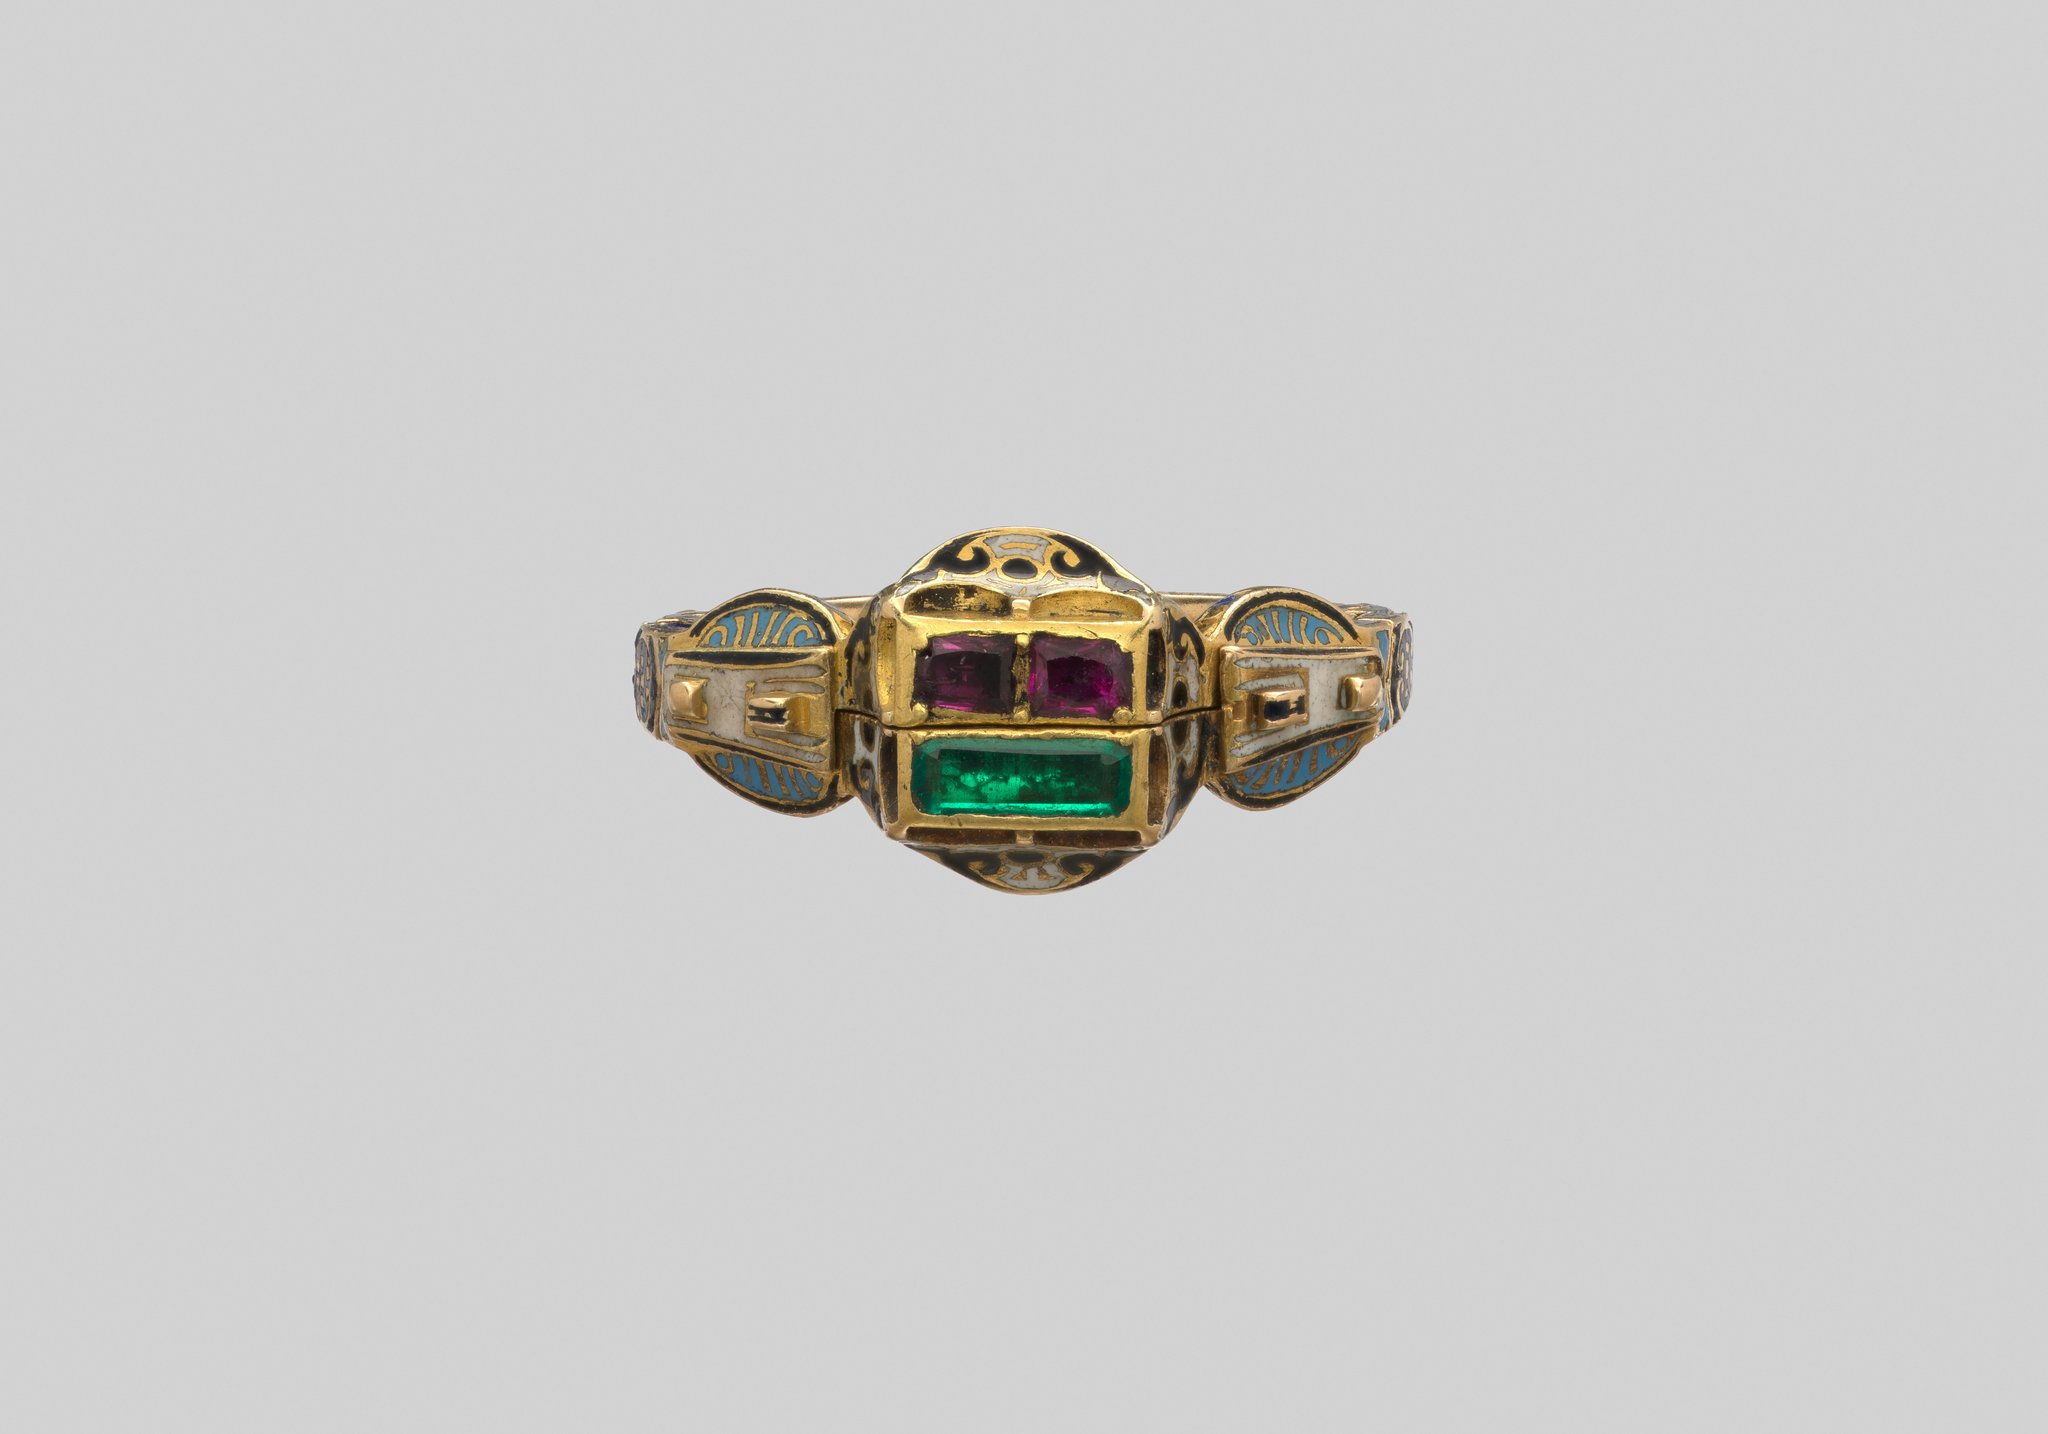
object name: gimmel ring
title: Gimmel ring (Twin ring)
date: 1551-1600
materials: gemstone, enamel, gold